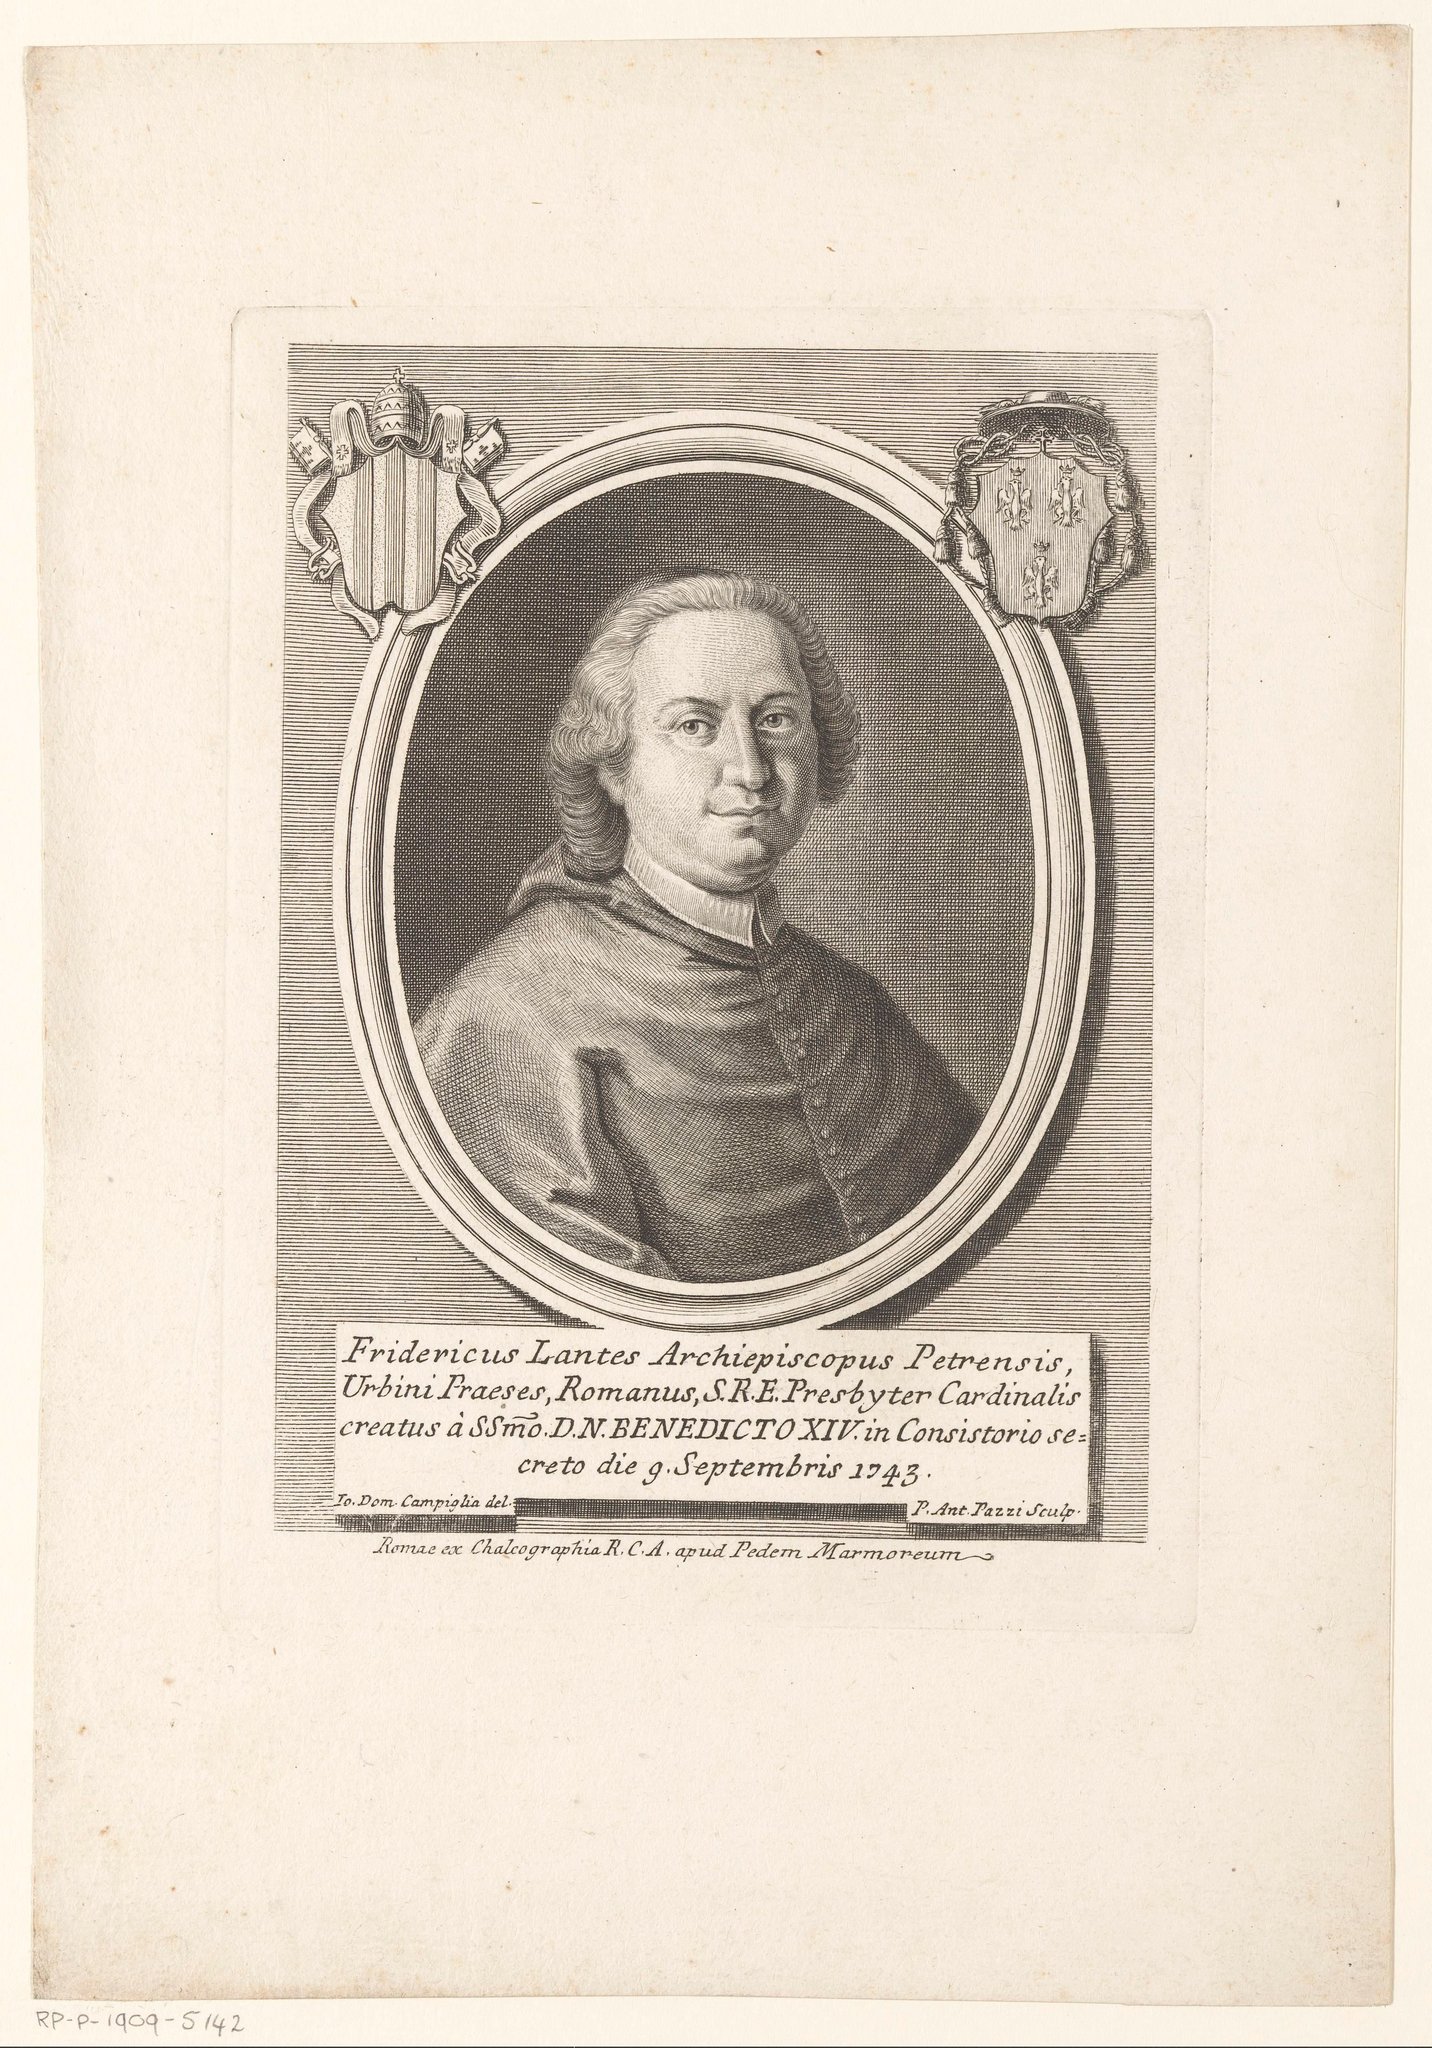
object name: print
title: Portretten van kardinalen met twee wapenschilden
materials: paper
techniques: engraving, etching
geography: italy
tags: rome, cardinal, historical persons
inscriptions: collector's mark: Lugt 2228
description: Prent uit een reeks van onbekende omvang met portretten van kardinalen. De prenten werden vanaf 1657 vervaardigd in opdracht van uitgever Giovanni Giacomo de’ Rossi, waarna de productie werd voortgezet onder leiding van zijn opvolgers Domenico de’ Rossi en Lorenzo Filippo de’ Rossi, en ten slotte onder leiding van de Calcographia R.C.A.